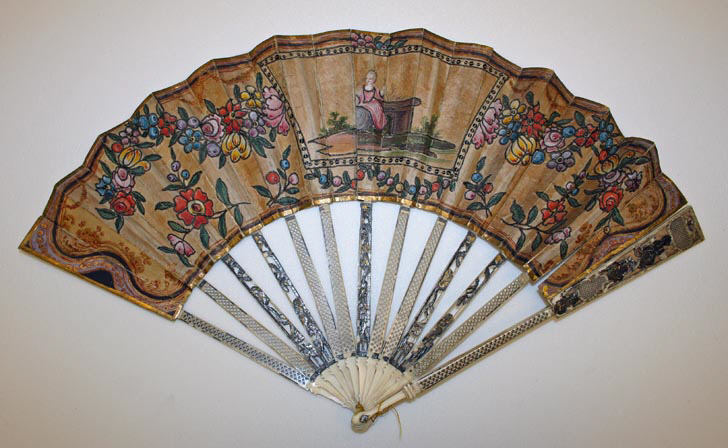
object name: fan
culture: french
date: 1701-1800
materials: ivory, leather, linen, metal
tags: women,flowers